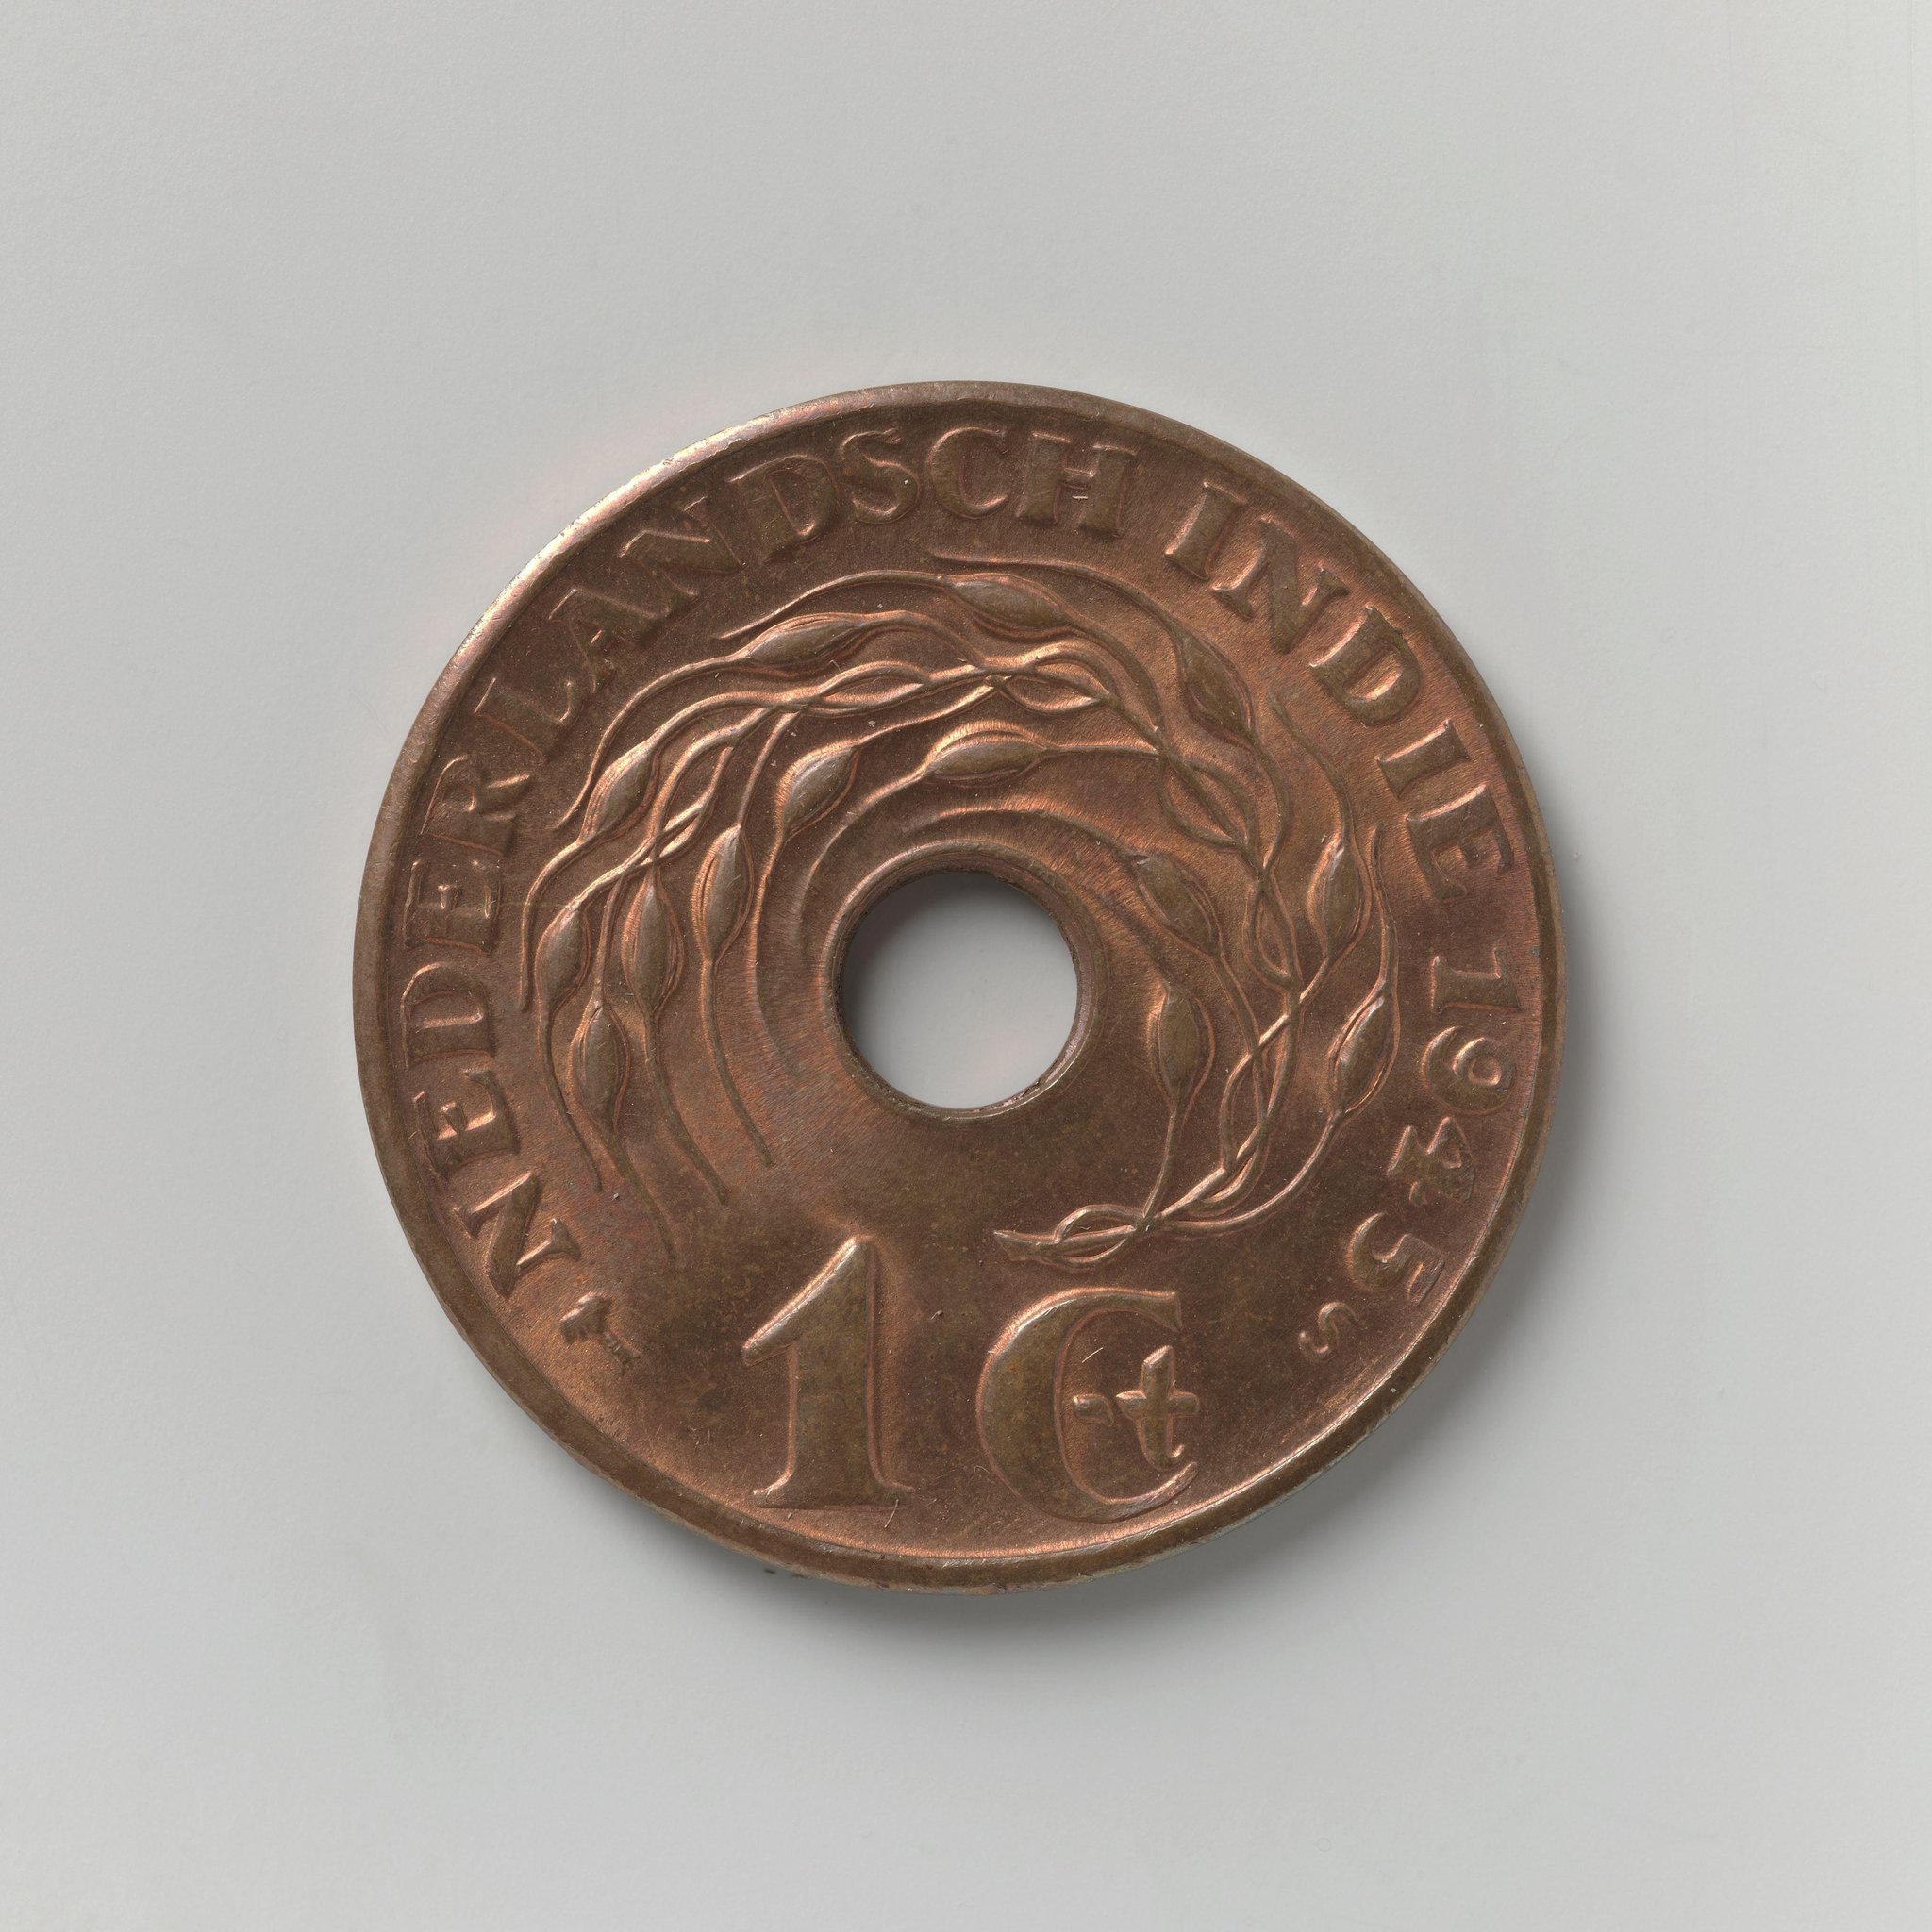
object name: coin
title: Nederlands Indië, cent,1945 S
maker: wilhelmina of the netherlands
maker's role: print maker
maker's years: 1880-1962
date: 1945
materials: bronze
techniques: striking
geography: san francisco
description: Bronzen munt. Voorzijde: rijst-aar. Als omschrift landsaanduiding en jaartal met onderaan waarde-aanduiding 1 Ct. Keerzijde: tweeregelig Maleis opschrift in Arabische letter- en orthografische tekens. Ter weerszijden van het onderste woord lotusbloemen op een Indische bloemversiering. Daaromheen omschrift in het Javaans. Centrale doorboring. Gladde rand.